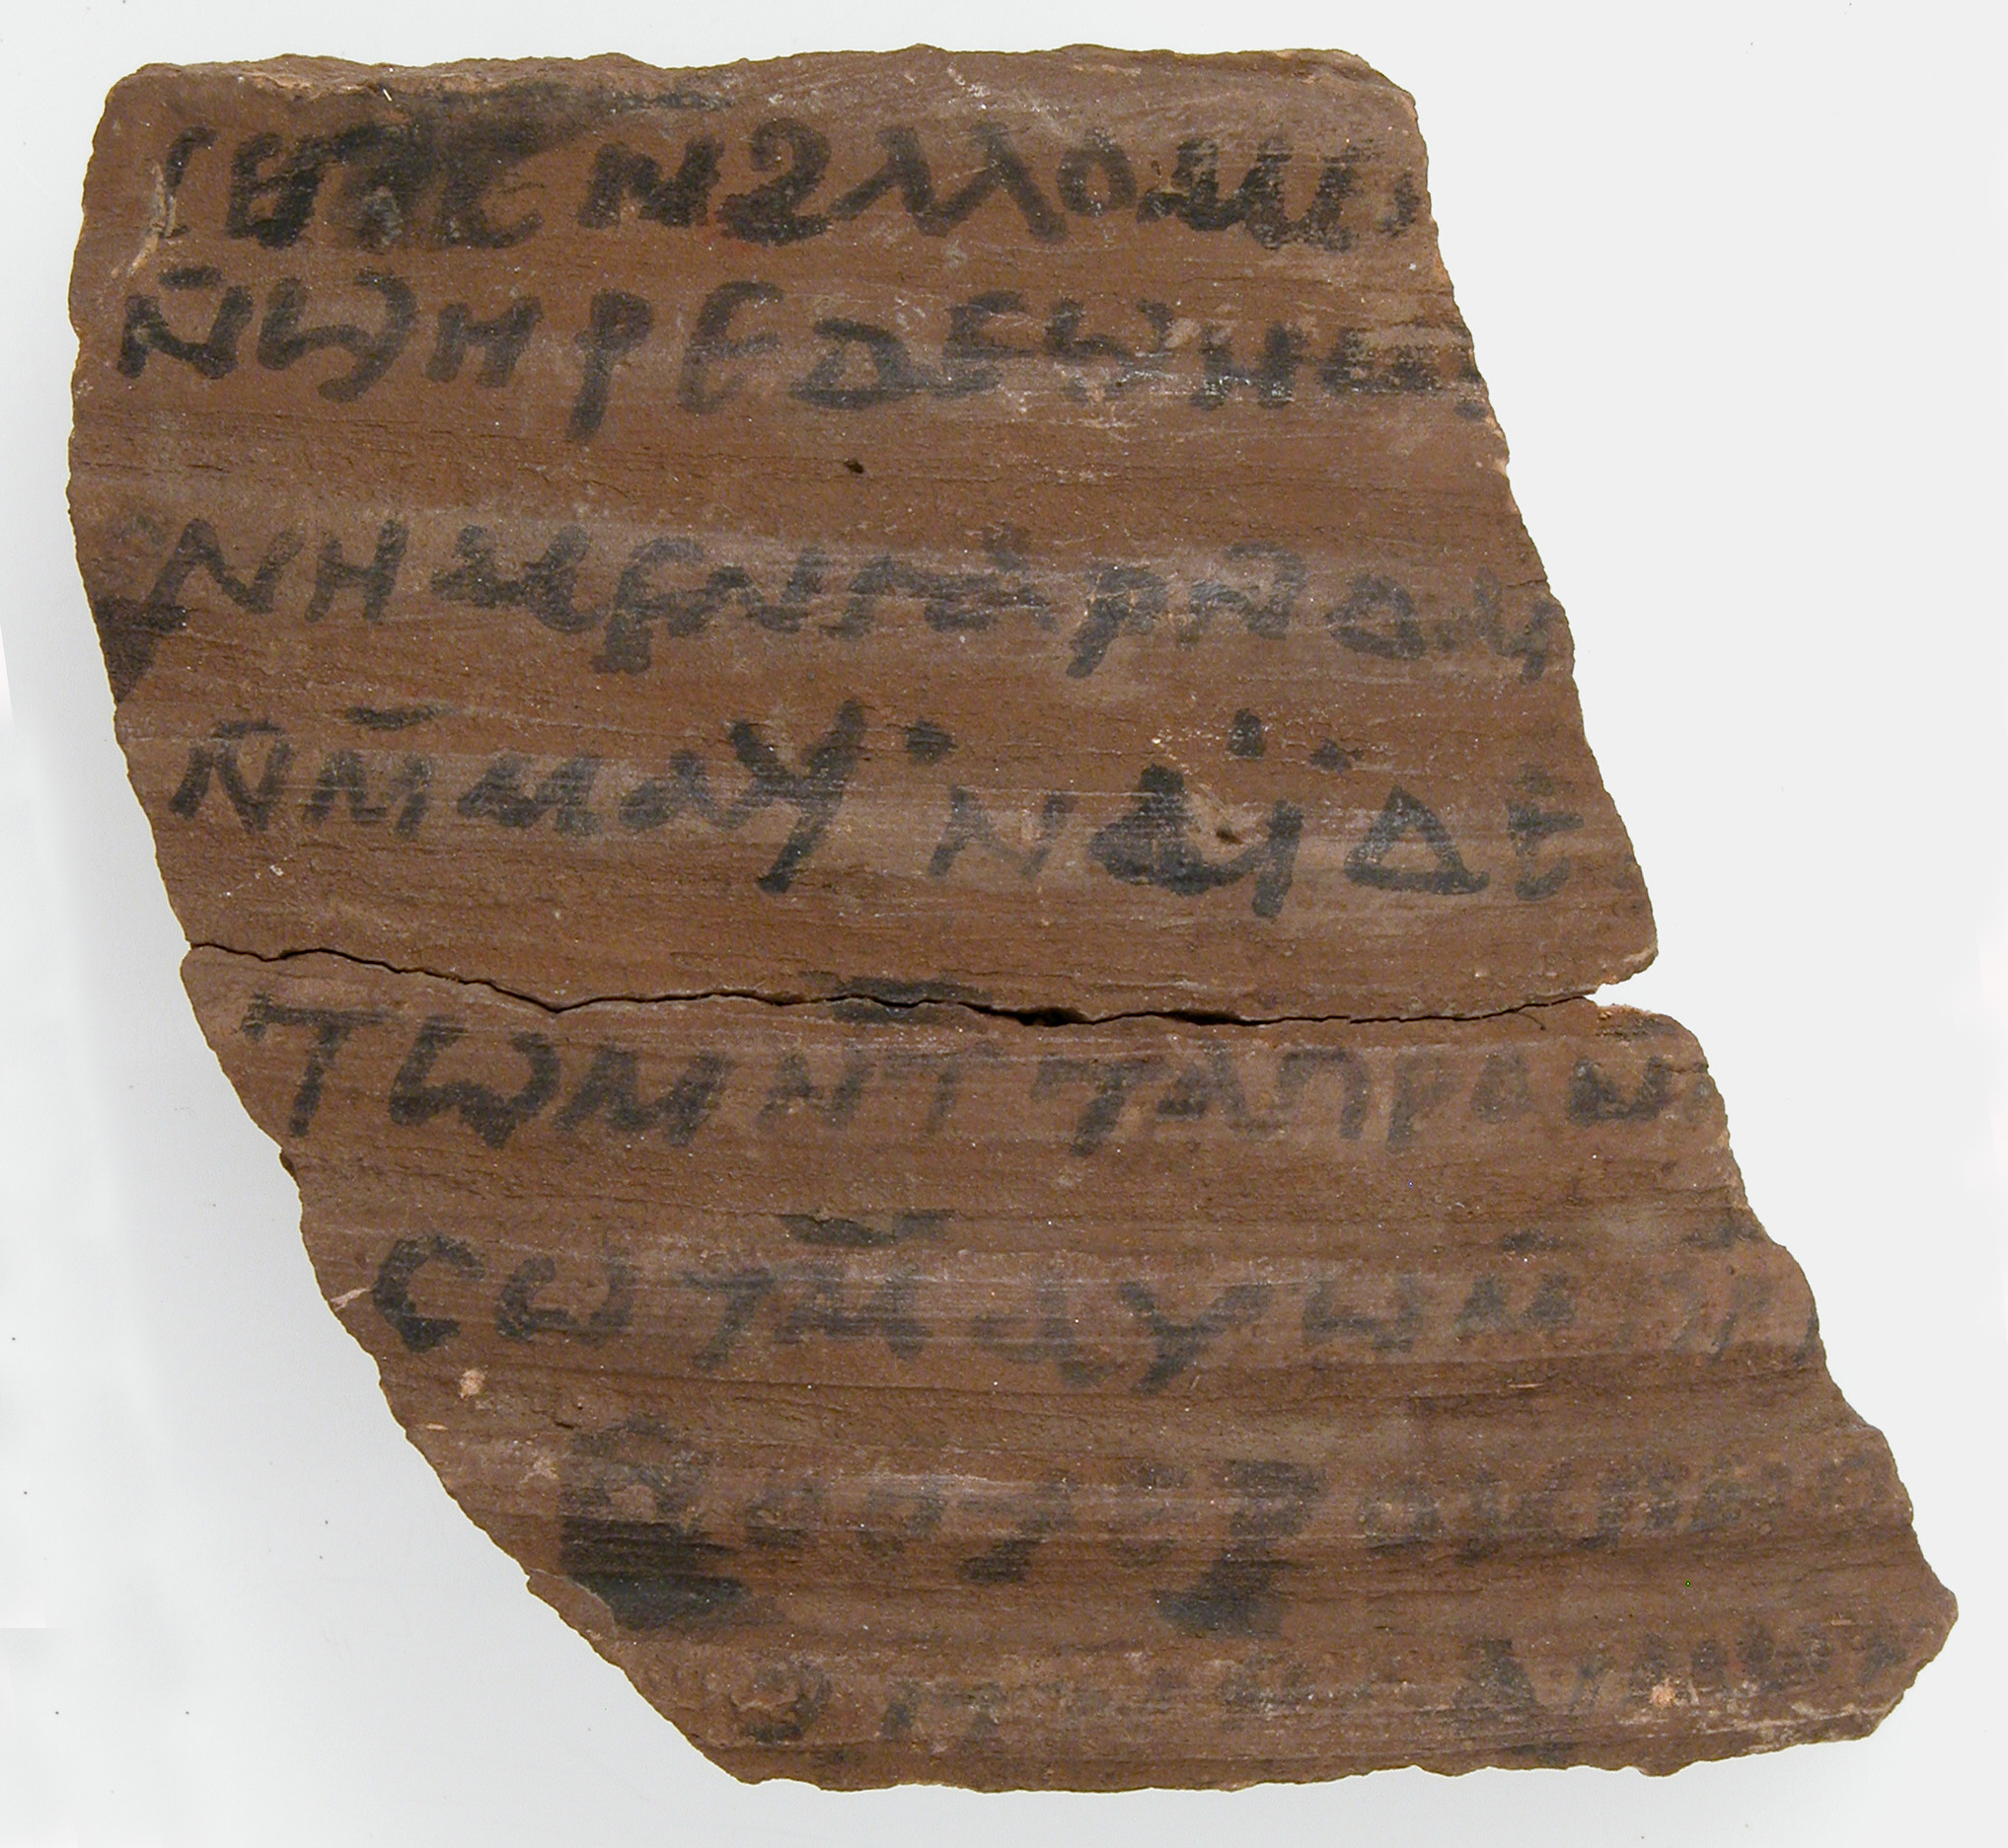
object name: ostrakon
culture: coptic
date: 600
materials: ink, pottery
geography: egypt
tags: coptic,documents